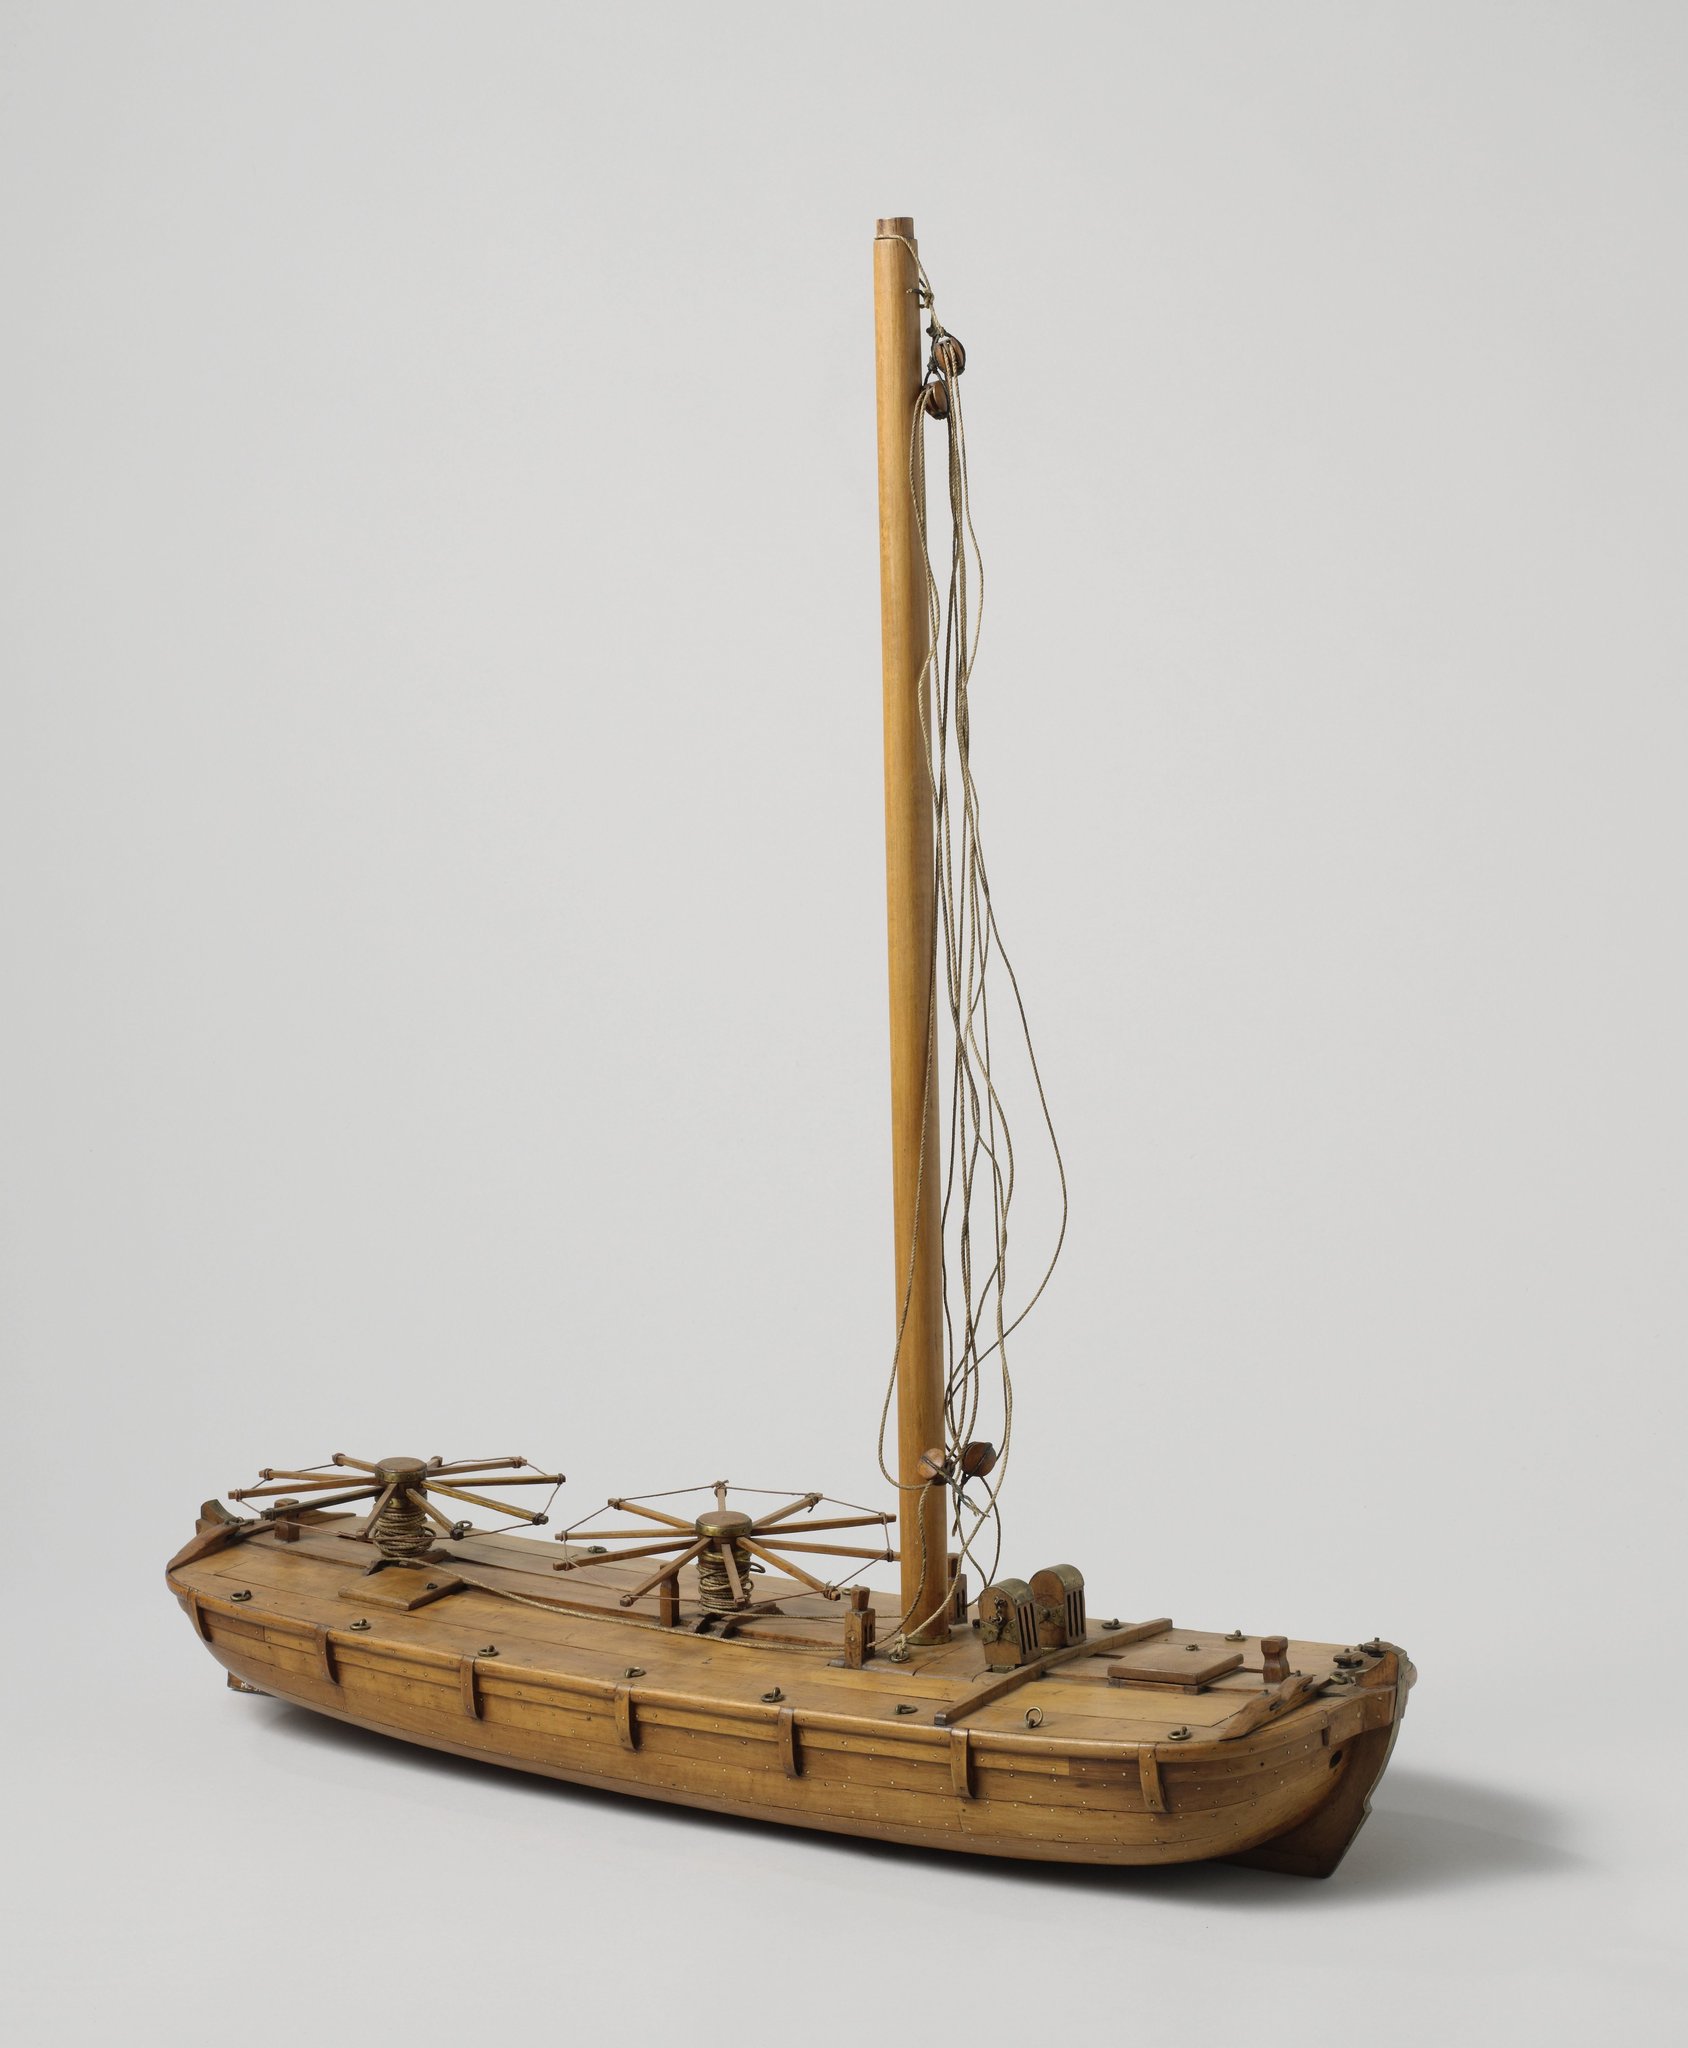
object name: ship model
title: Model of a Careening Hulk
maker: Anonymous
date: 1800-1858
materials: brass, ivory, fiber, wood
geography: netherlands